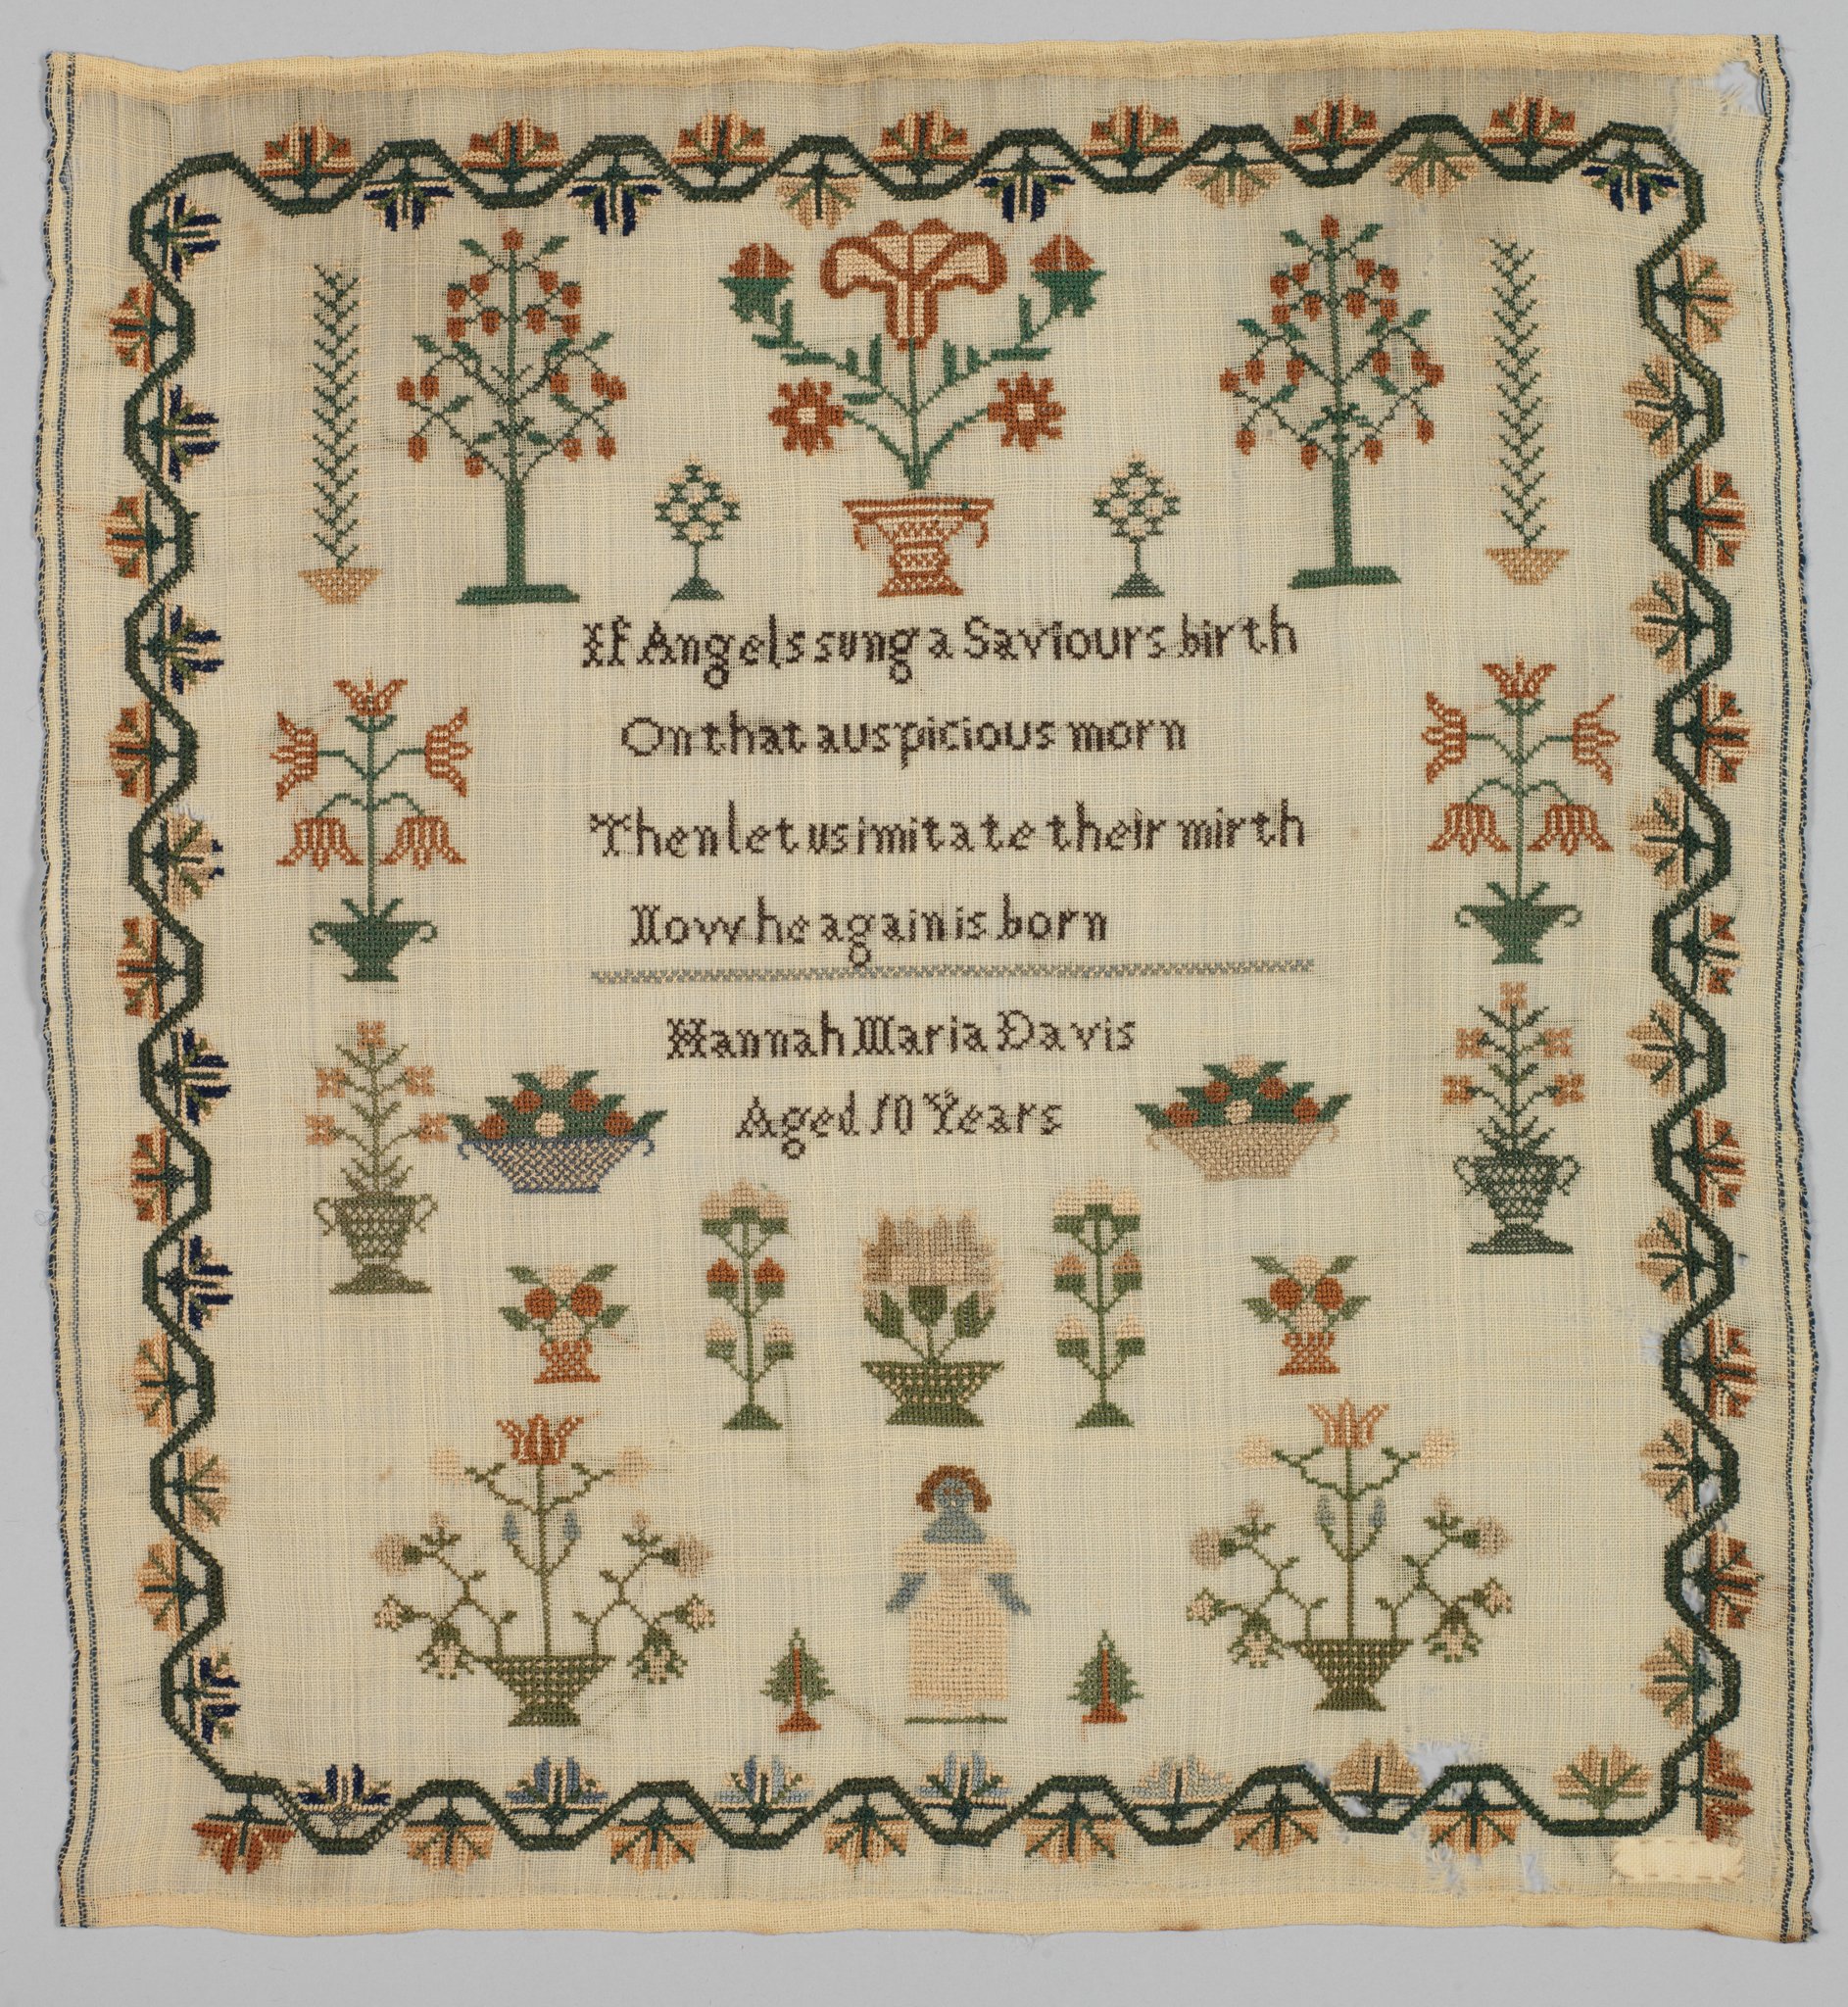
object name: sampler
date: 1801-1900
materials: canvas, silk, wool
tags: flowers